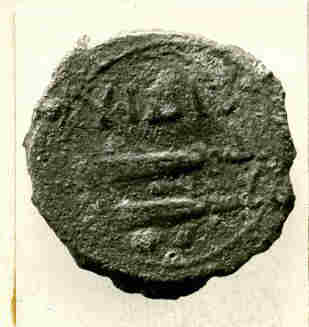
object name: coin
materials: copper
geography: iran